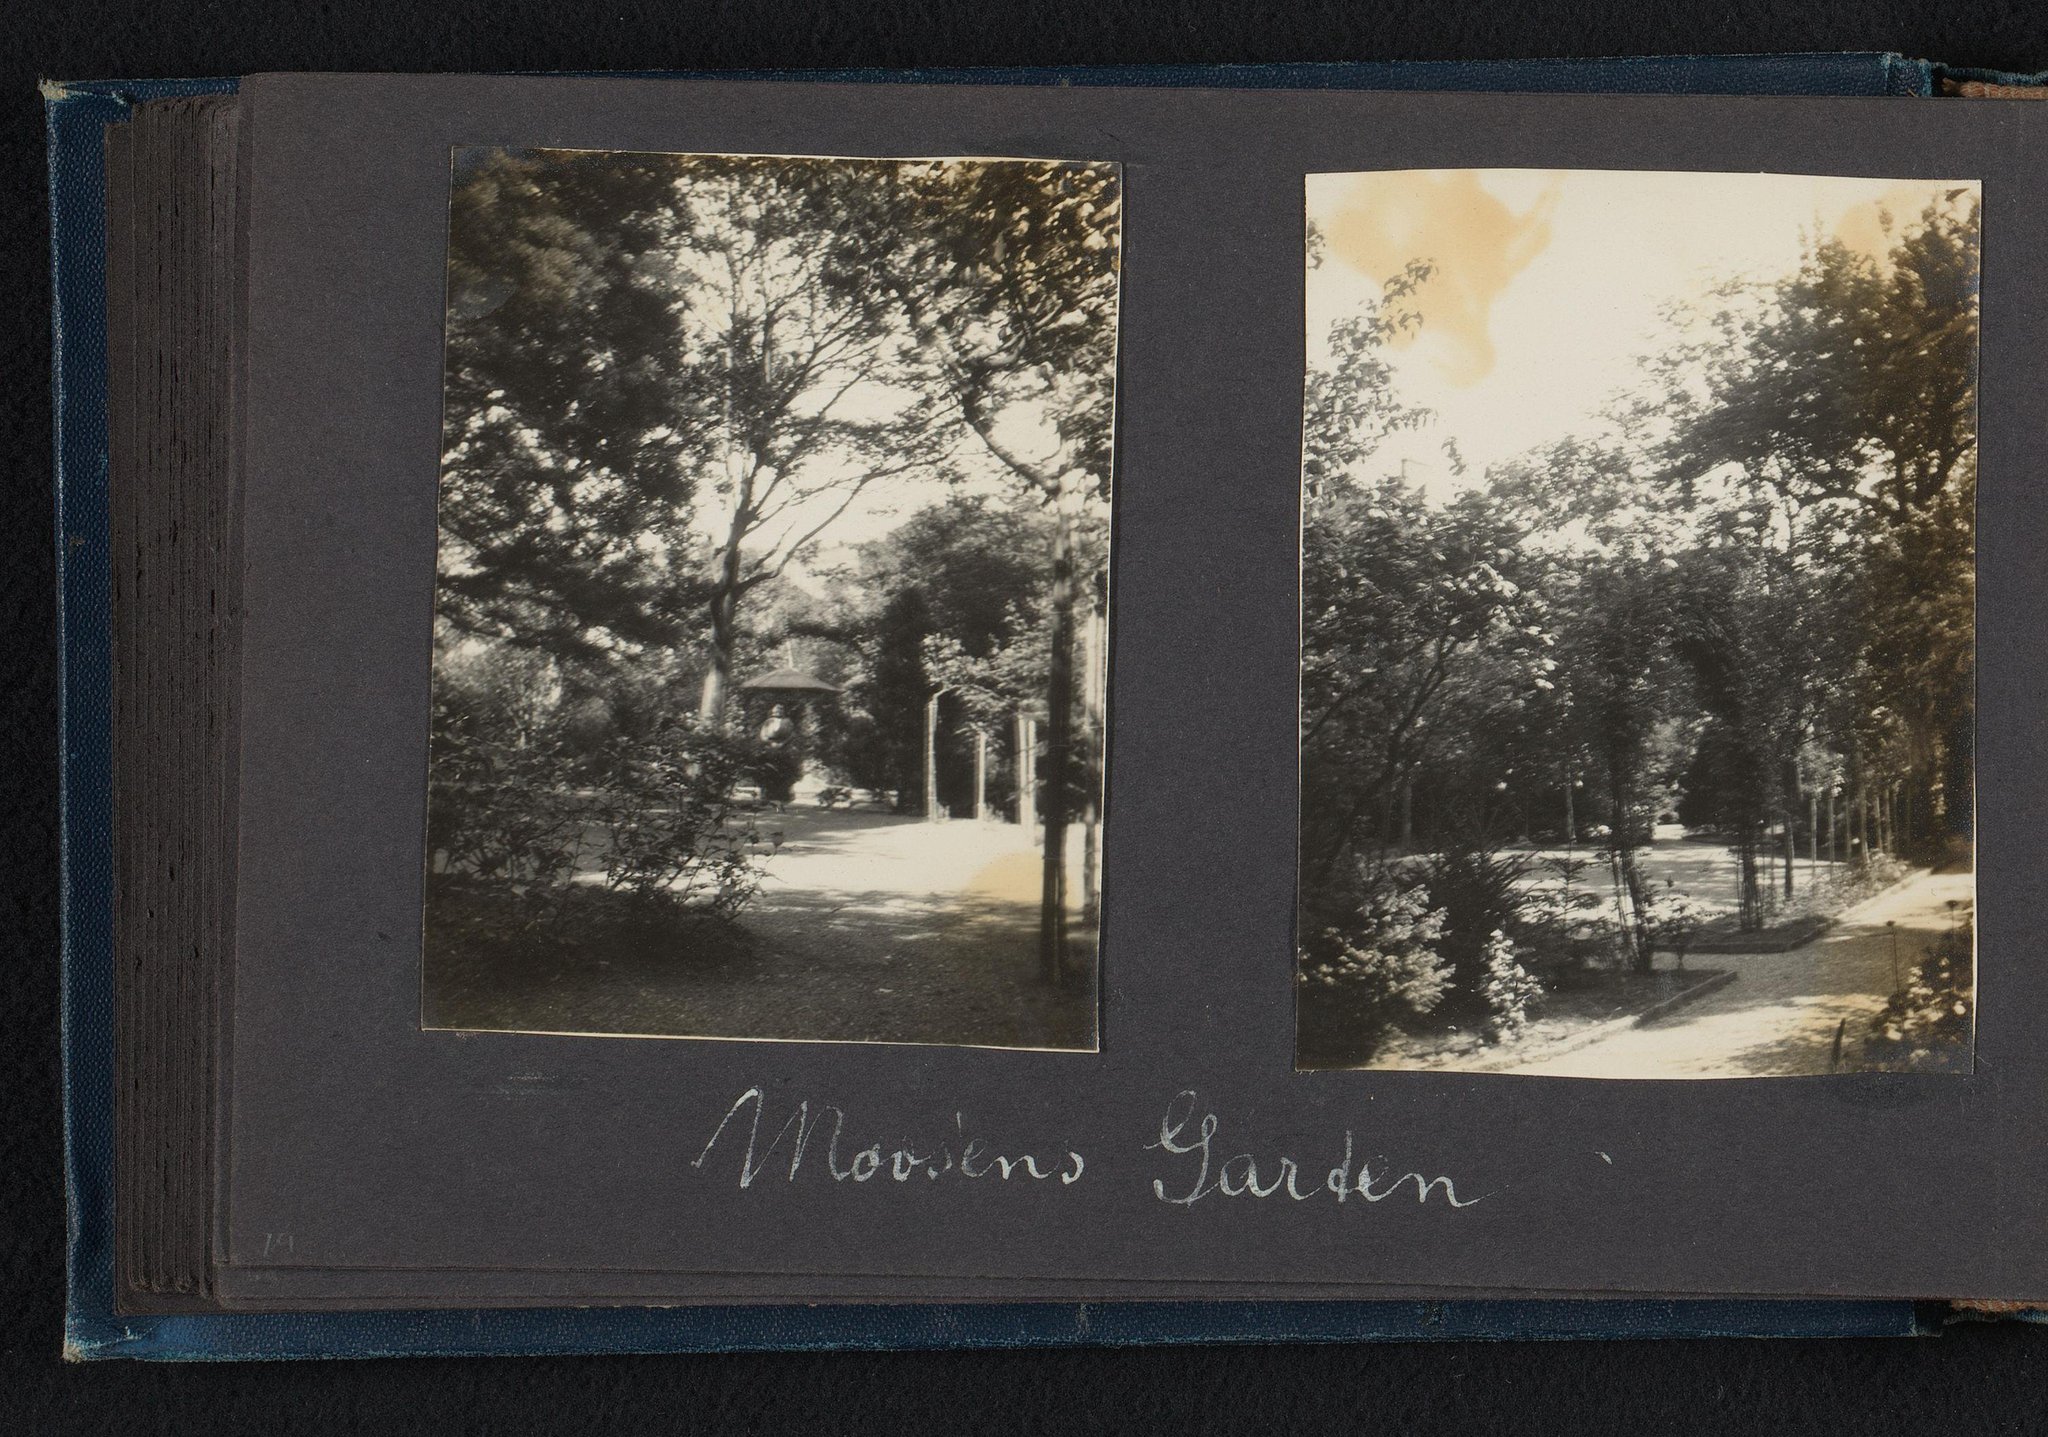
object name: album leaf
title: Tuin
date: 1916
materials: paper, photographic support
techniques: gelatin silver print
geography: germany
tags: else wachenheimer-moos, garden, germany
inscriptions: inscription: ‘Moos'ens Garten’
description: Albumblad met twee foto's van de tuin van de familie Moos. Onderdeel van het fotoalbum van Else Wachenheimer-Moos en haar broers Arthur en Willy Moos en anderen in de periode 1913-1918.